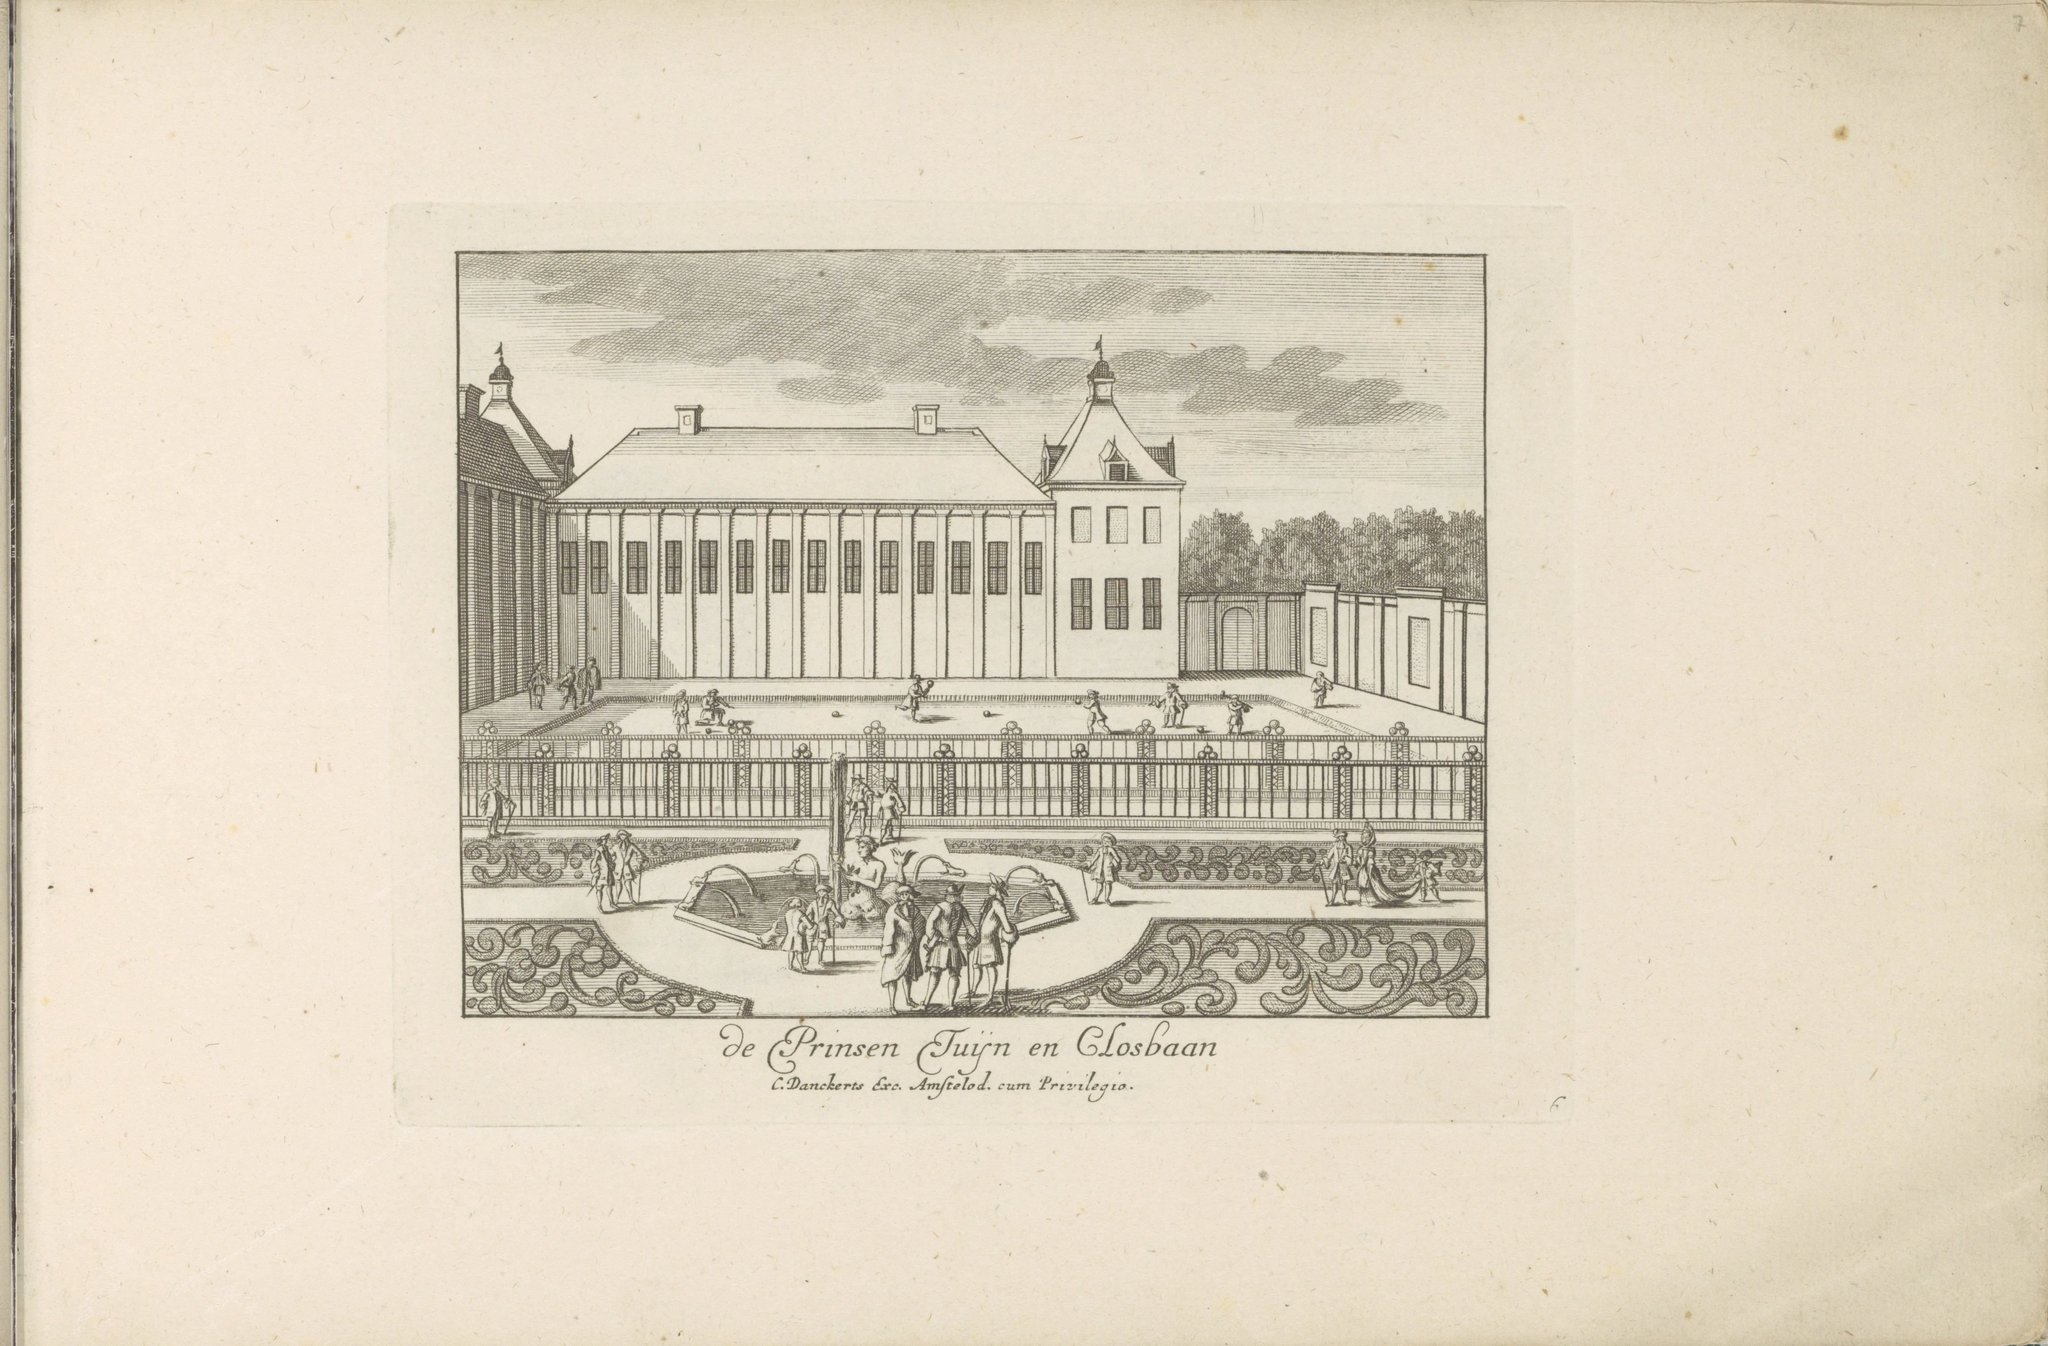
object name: print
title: Nette Afbeeldinge Van de Lust-Tuin, en 't Hof-Gebouw, Van zyn Kooninglyke Majesteit van Groot-Brittanje, enz. enz. enz. Geleegen op 't Loo In Gelderland (...) / Representation au Naturel de Loo En Gueldre. Maison de plaisance de sa Majesté Britannique (...)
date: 1696-1718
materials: paper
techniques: etching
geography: amsterdam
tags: french or architectonic garden; formal garden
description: Gezicht op de Koningstuin bij Paleis Het Loo met de klosbaan. Prent maakt deel uit van een album.